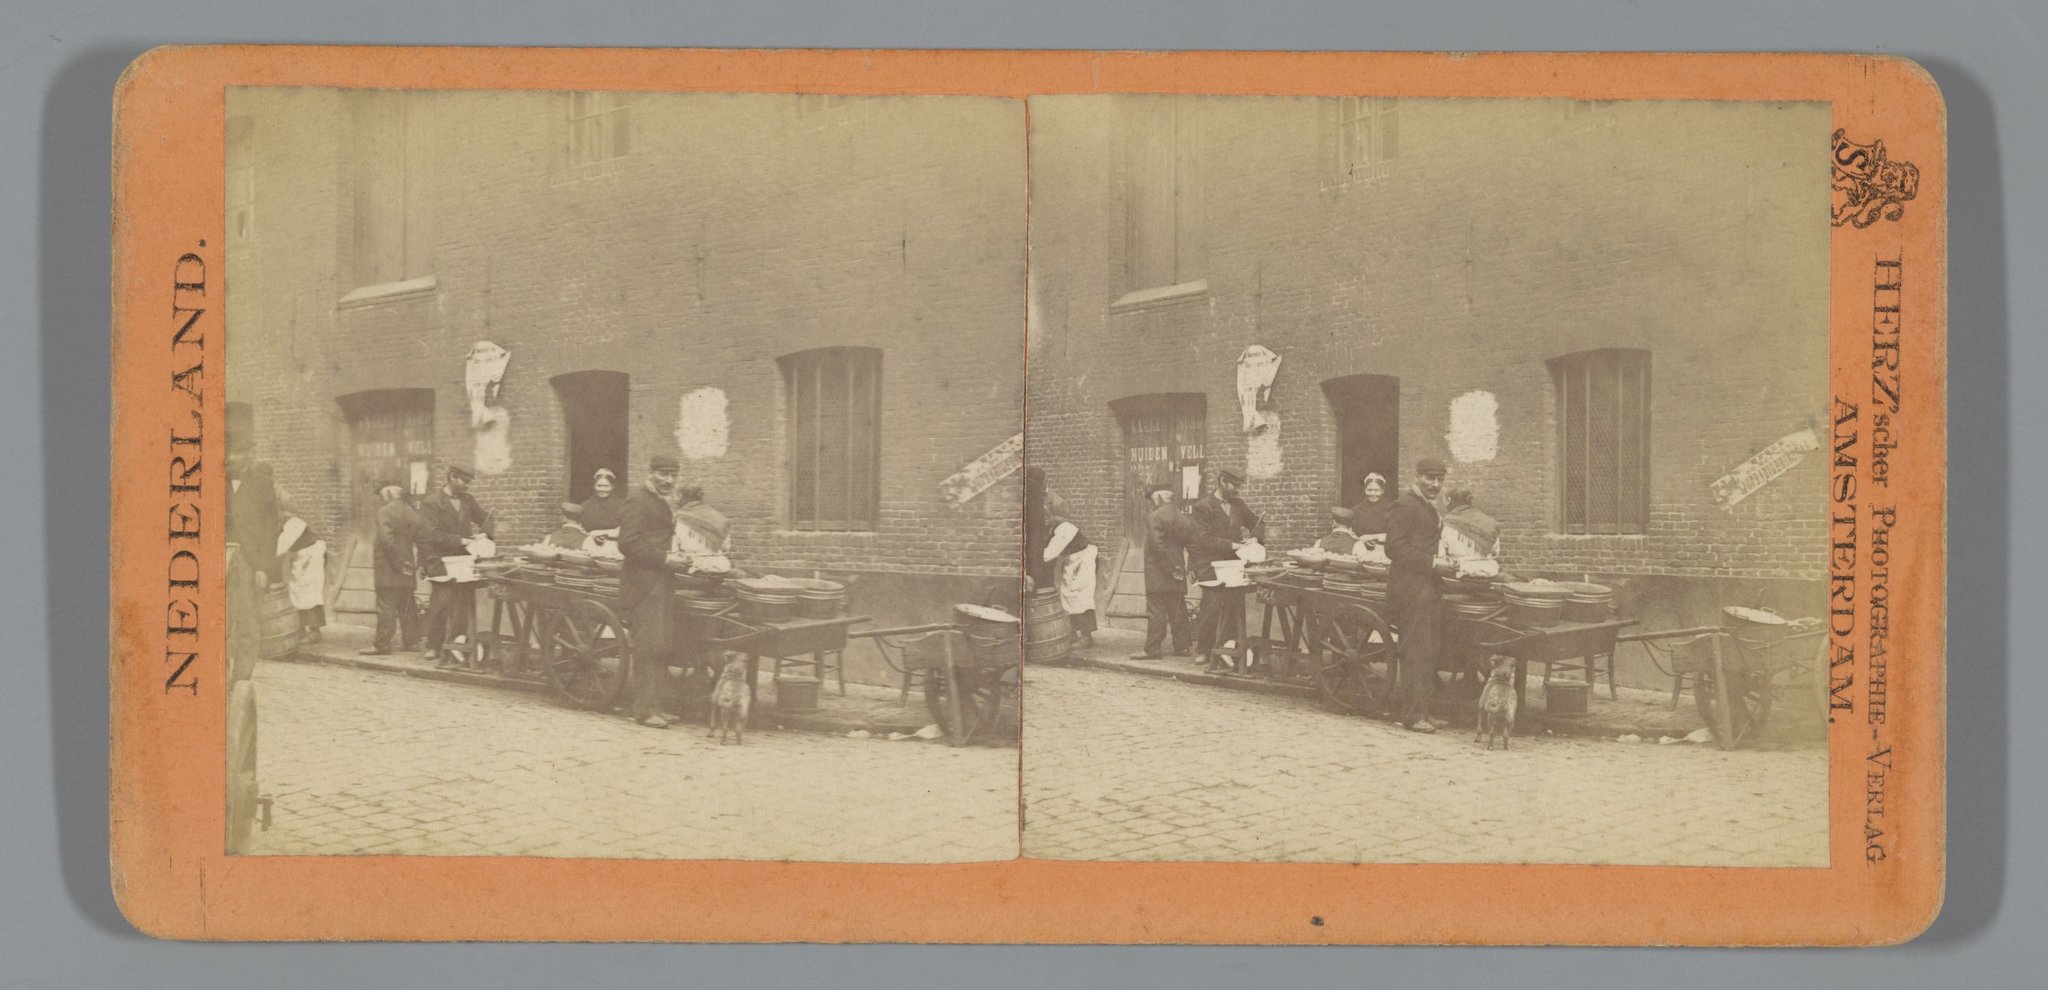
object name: stereograph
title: Straatbeeld met marktkraam, Nederland, vermoedelijk Amsterdam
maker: sigmund löw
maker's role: publisher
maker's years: 1845-1920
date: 1892-1902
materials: cardboard, paper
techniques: albumen print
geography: amsterdam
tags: stall, booth (~ market), netherlands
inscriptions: number: ‘344’